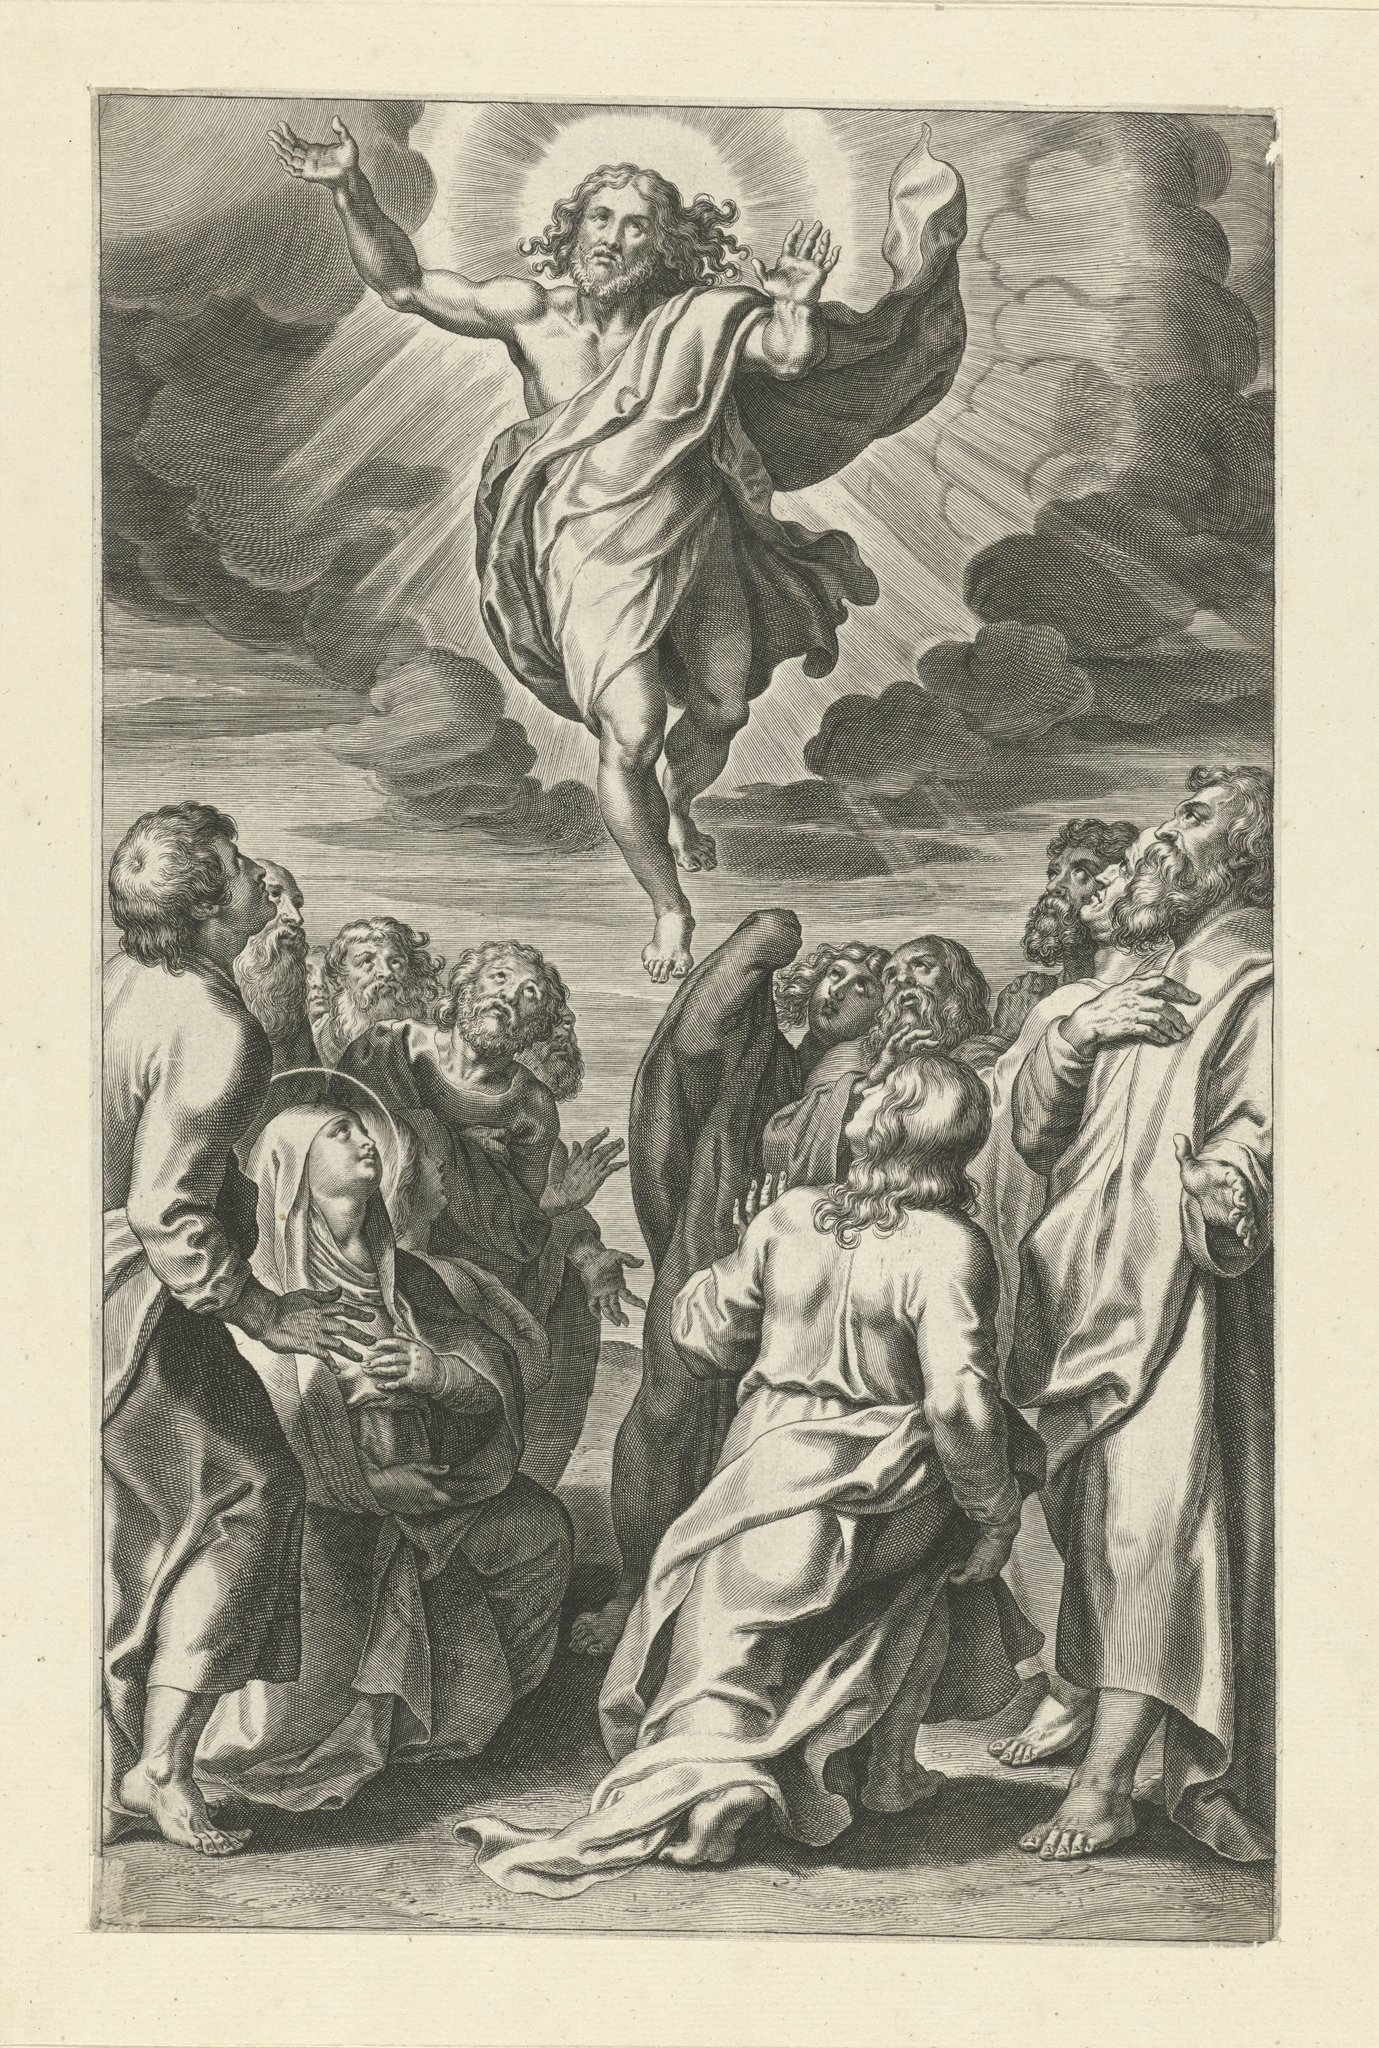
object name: print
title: Hemelvaart van Christus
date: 1612-1616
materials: paper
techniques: engraving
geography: antwerp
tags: the ascension (christ surrounded by radiant light or in a mandorla)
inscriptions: collector's mark: Lugt 240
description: Christus wordt naar de hemel gevoerd. Rondom hem zijn leerlingen en Maria. De prent is deel van een serie met scènes uit het Oude en Nieuwe Testament.